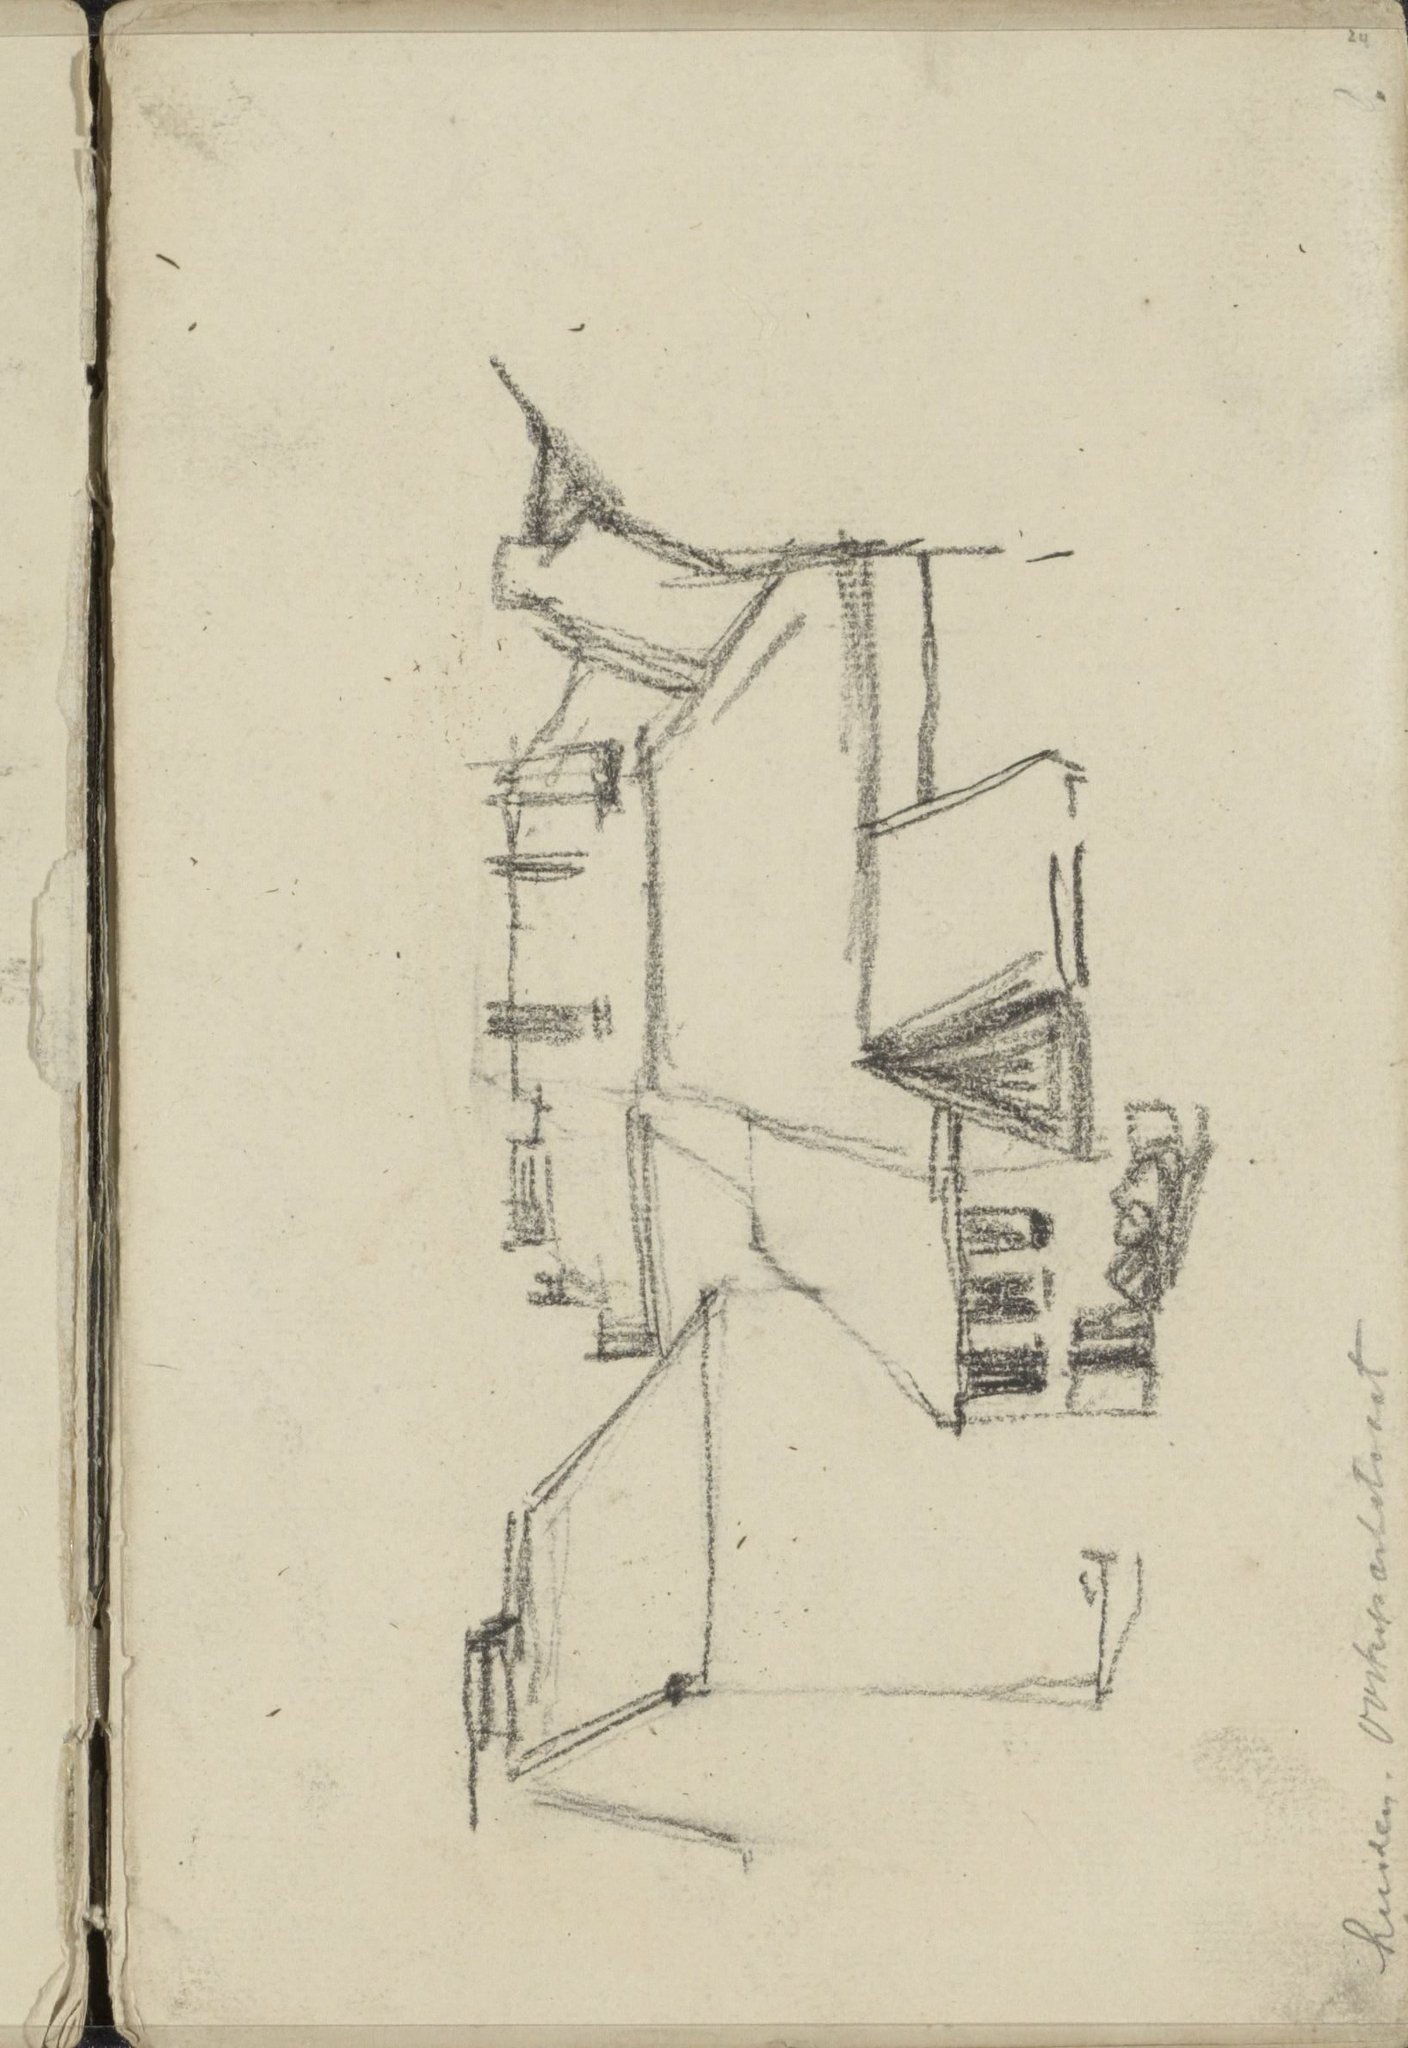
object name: sketchbook leaf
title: Huizen in de Oosterparkstraat te Amsterdam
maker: george hendrik breitner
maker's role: draughtsman, painter, print maker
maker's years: 1857-1923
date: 1887-1891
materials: chalk, paper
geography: amsterdam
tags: urban housing, street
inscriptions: annotation: ‘huizen. Oosterparkstraat’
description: Pagina 24 uit een schetsboek met 17 bladen.